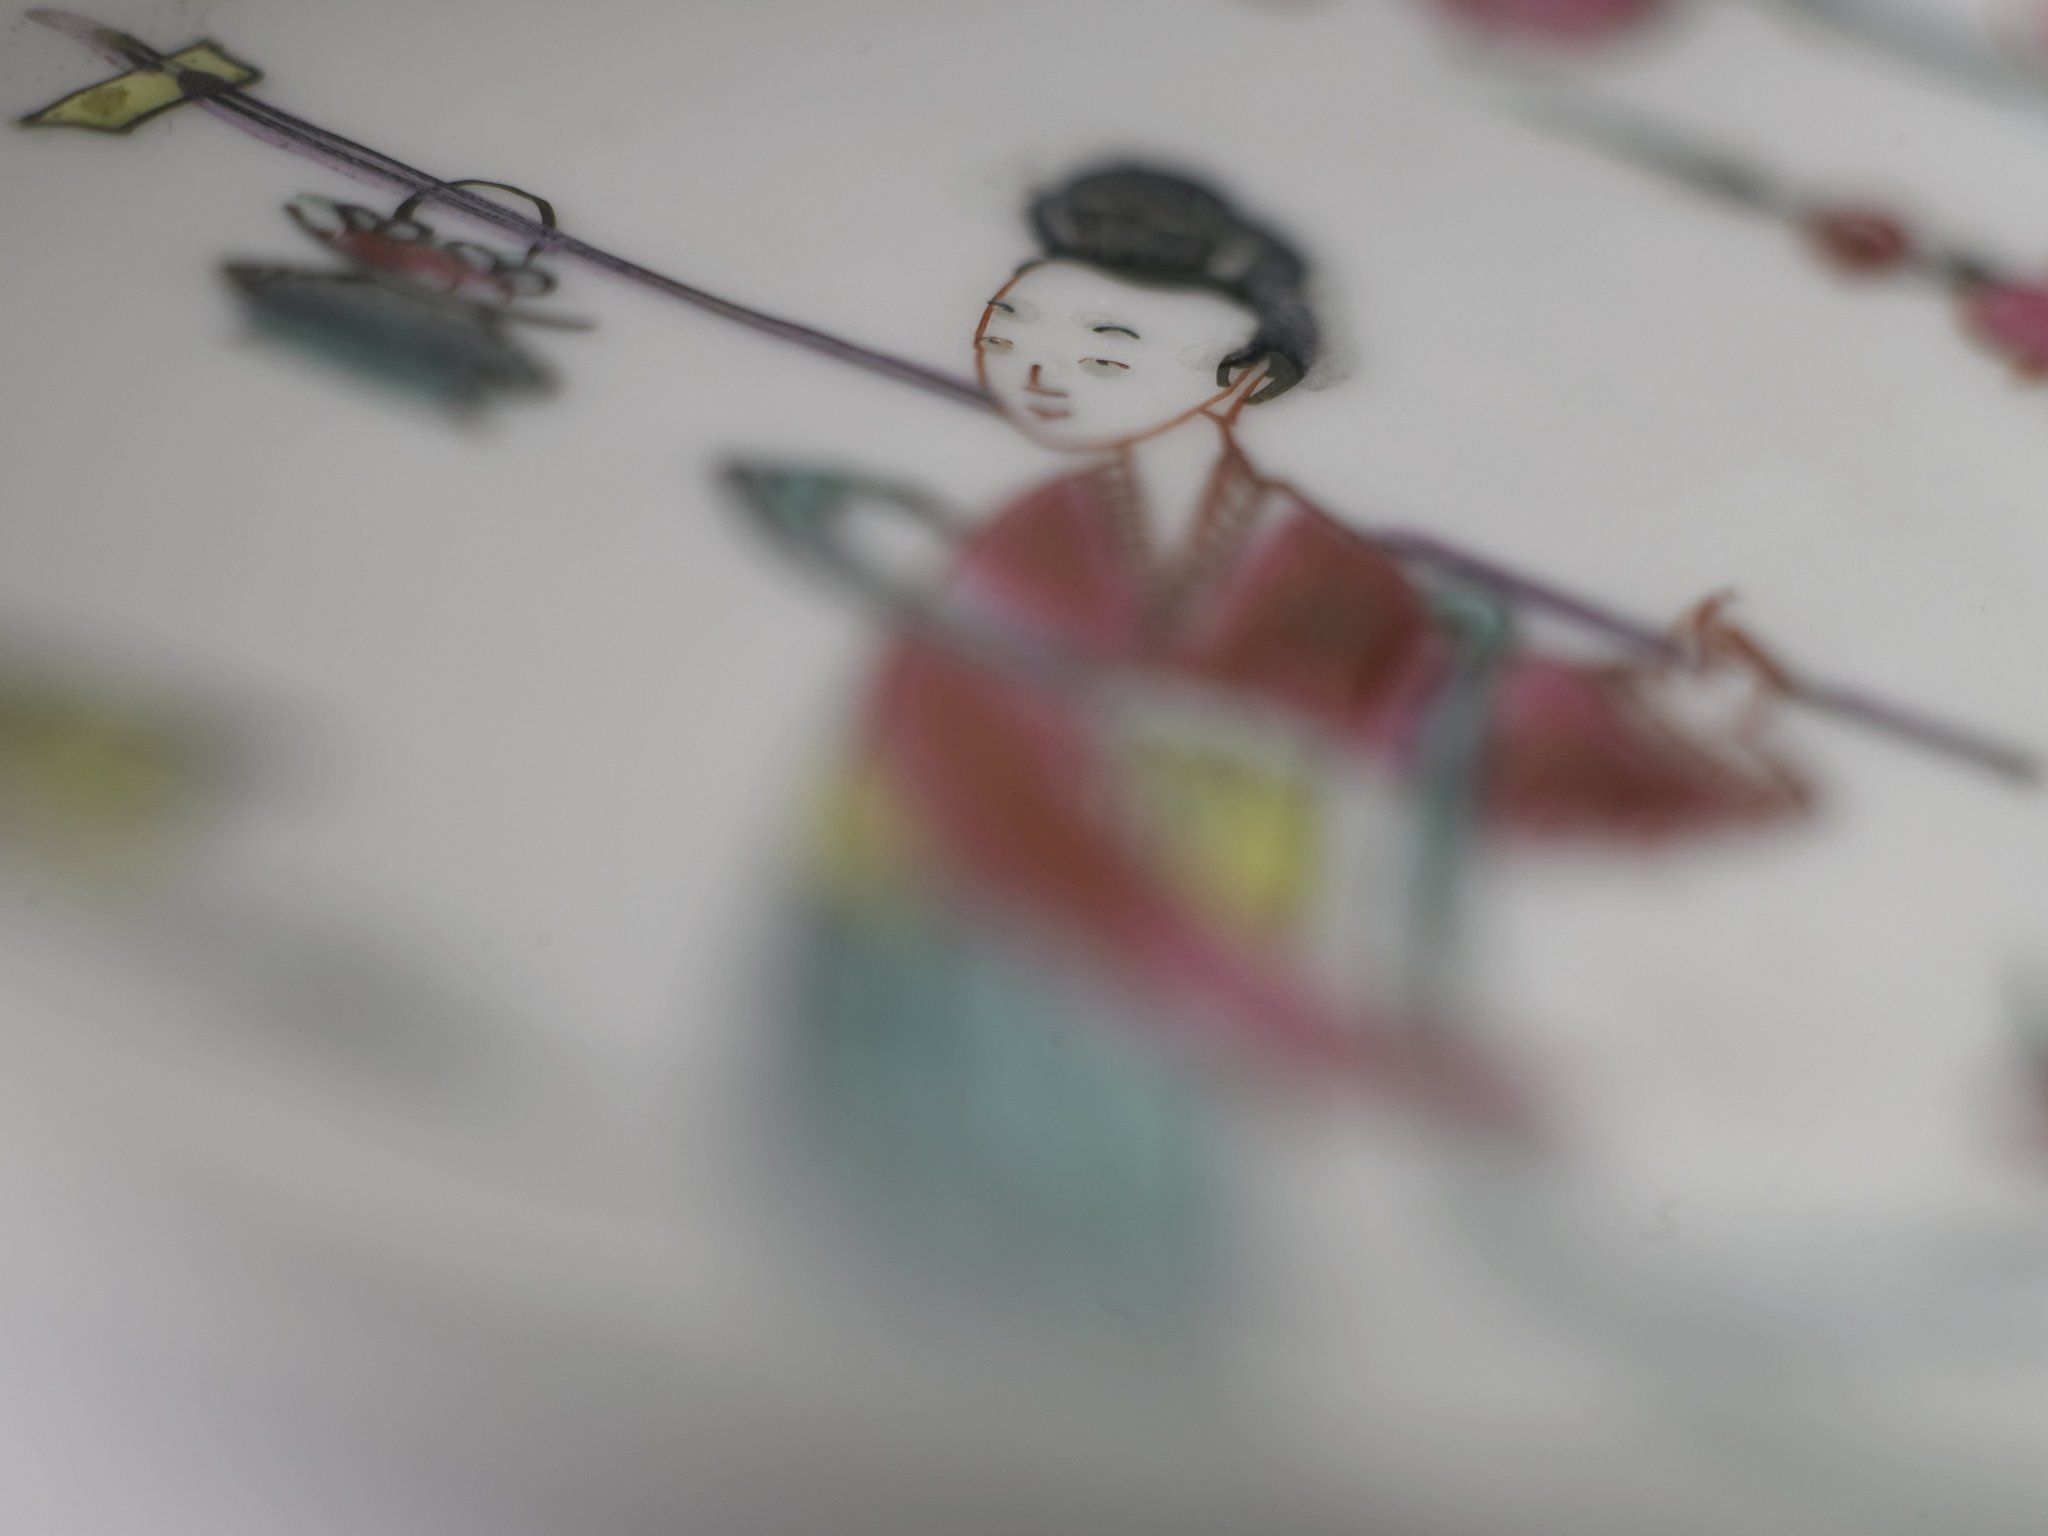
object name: kop en schotel, kop en schotel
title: Bell-shaped cup and saucer with Lan Caihe in a landscape with a deer and bat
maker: Anonymous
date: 1725-1749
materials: glaze, paint, porcelain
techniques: firing, turning, vitrification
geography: china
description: Klokvormige kop en schotel van porselein, beschilderd op het glazuur in blauw, rood, roze, groen, geel en zwart. Op het plat van de schotel een voorstelling van Lan Caihe (Lan Ts'ai Ho) met zijn fruitmand in een landschap bij een rots en een prunus; naast hem ligt een hert met een paddenstoel (lingzhi) in zijn bek en vliegt een vleermuis. De kop met dezelfde decoratie. Een barst en een chip in de rand van de schotel. Famille rose met famille verte.